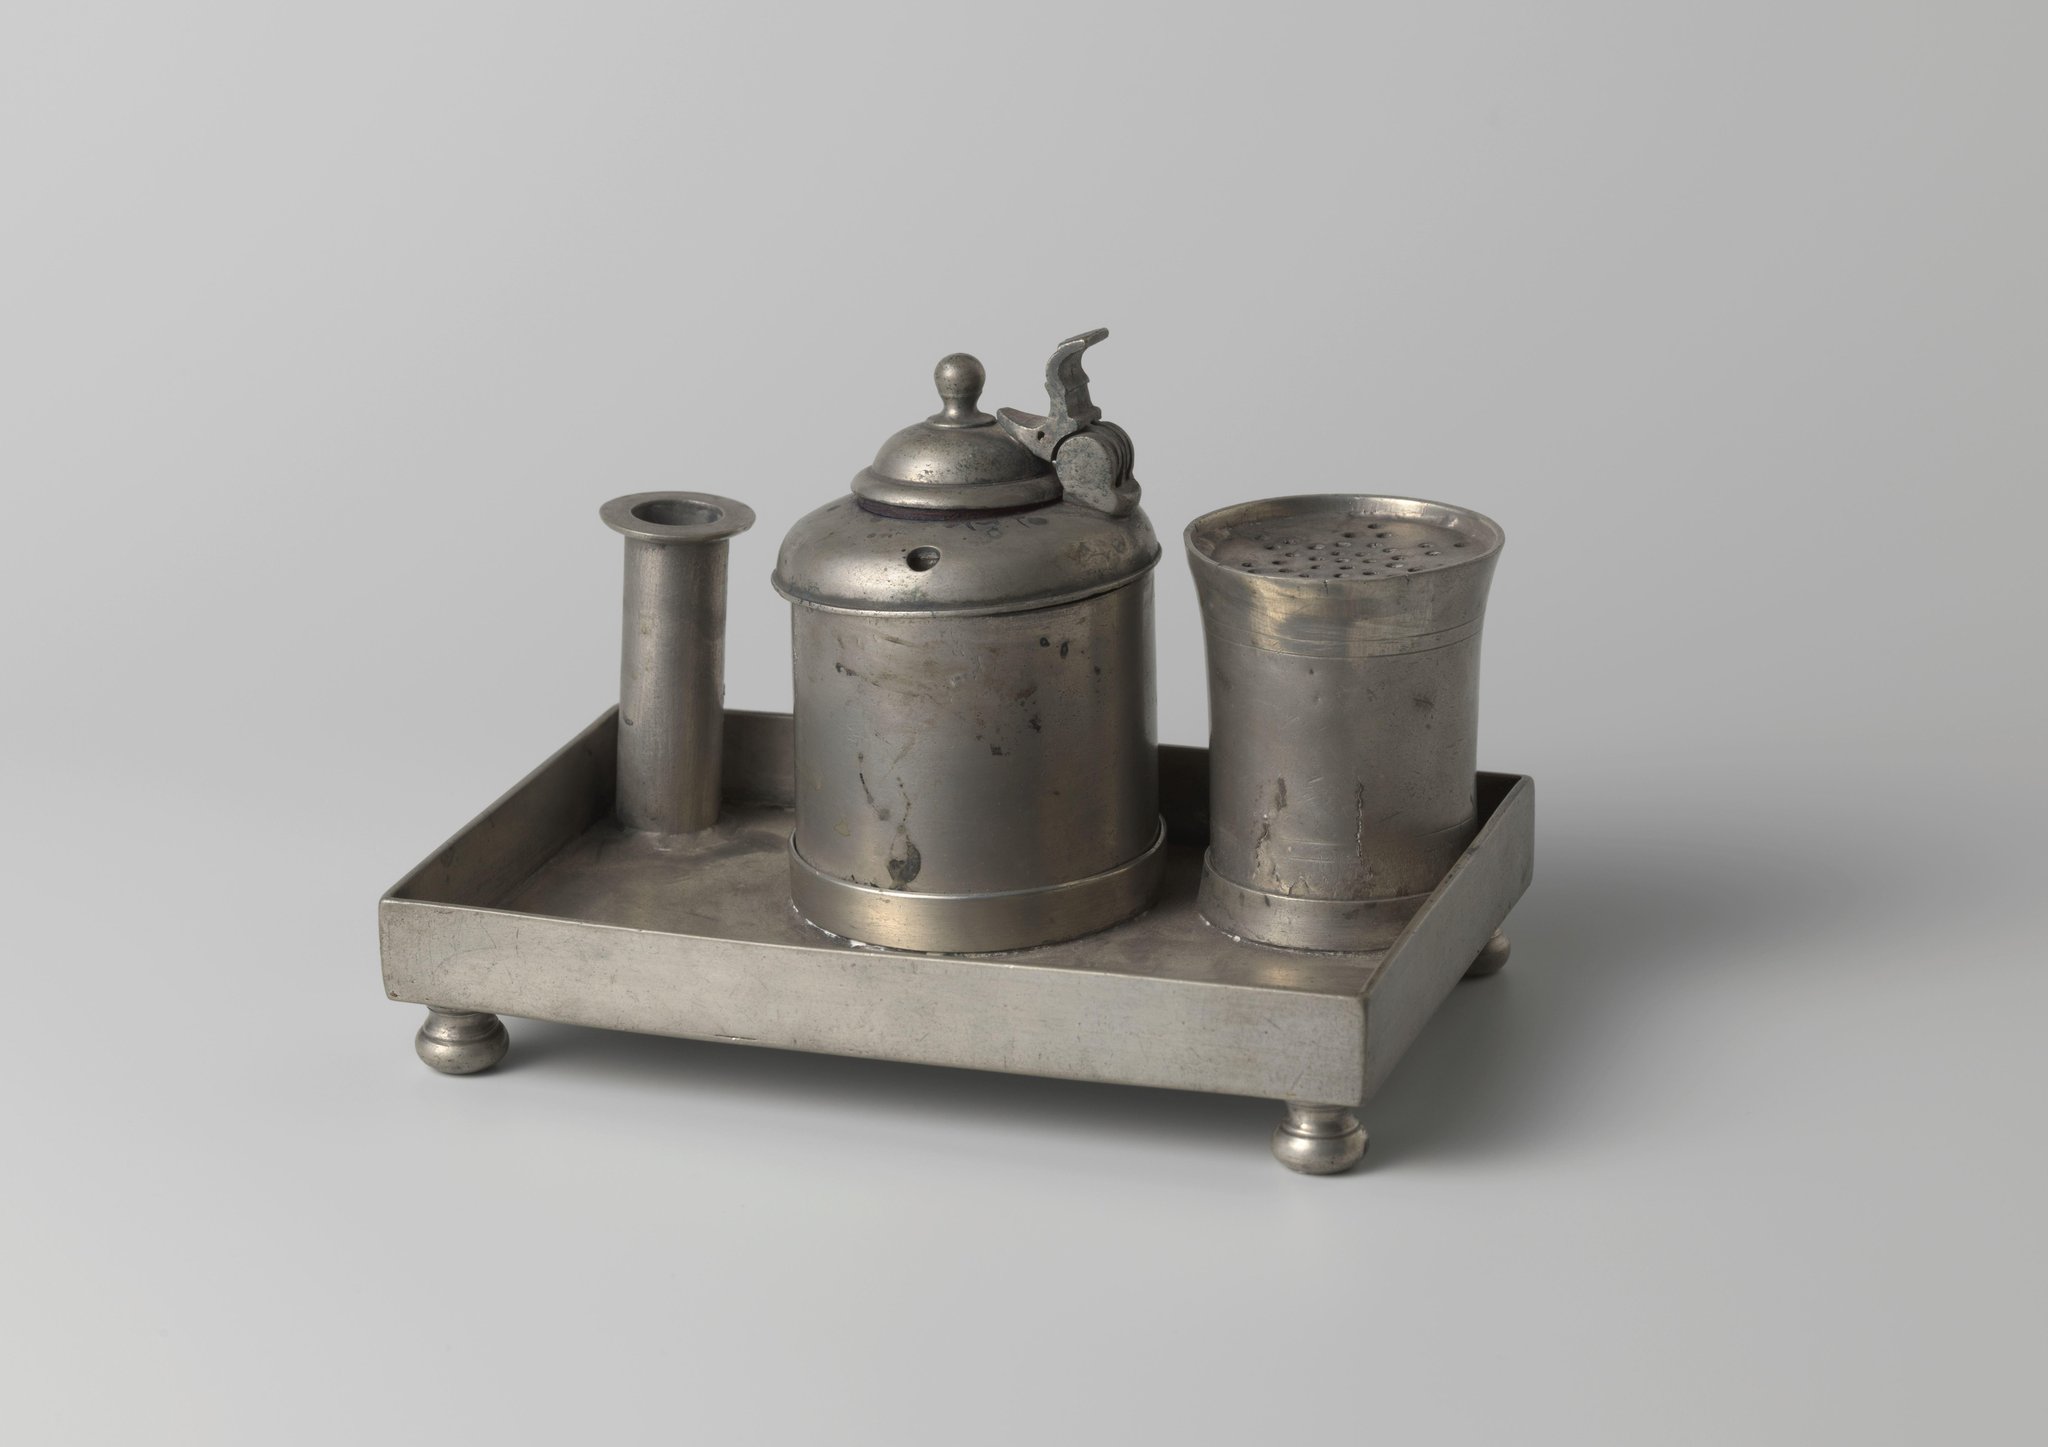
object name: inkwell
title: Inktpot van inktstel van tin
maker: Anonymous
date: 1850-1900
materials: tin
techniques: casting, turning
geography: netherlands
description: De inktpot van tin heeft een cylindrisch lichaam. De binnenbak is smaller en de gewelfde bovenzijde valt over de buitenpot. In het midden van de welving een klokvormig deksel dat met een tweekakig scharnier is te openen.